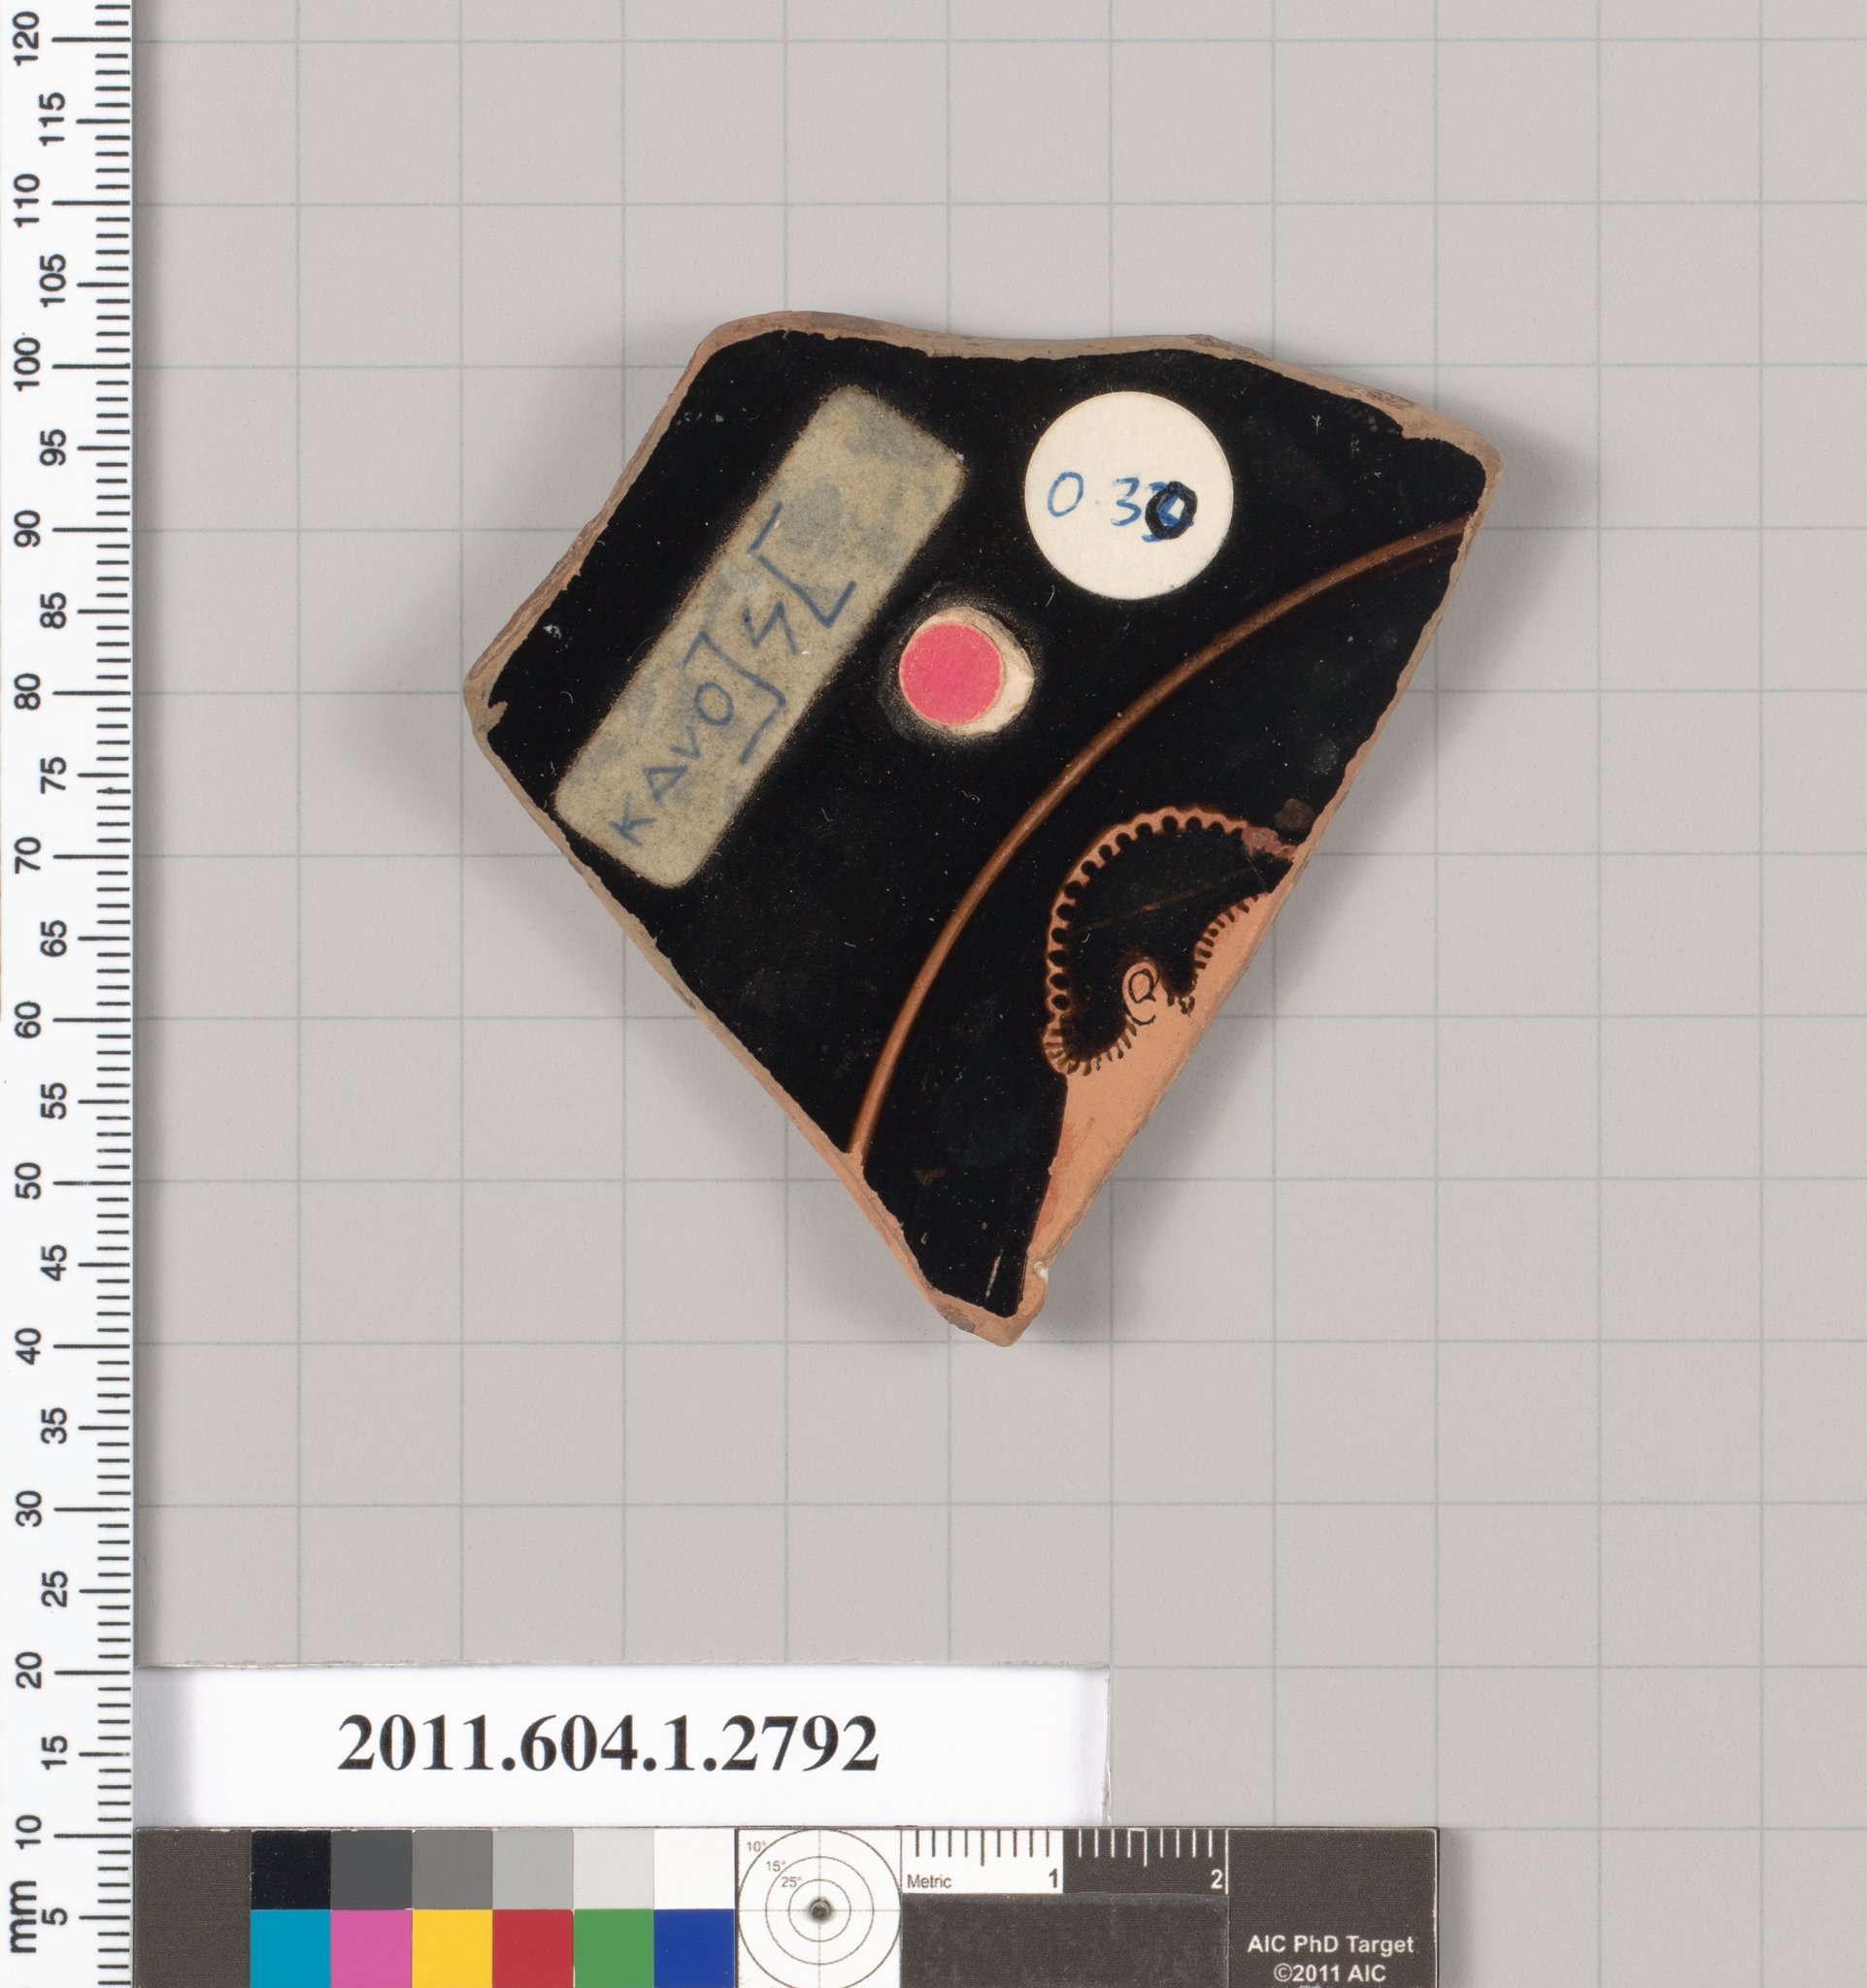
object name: kylix fragment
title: Terracotta fragment of a kylix (drinking cup)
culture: greek, attic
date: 520-500 BCE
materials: terracotta